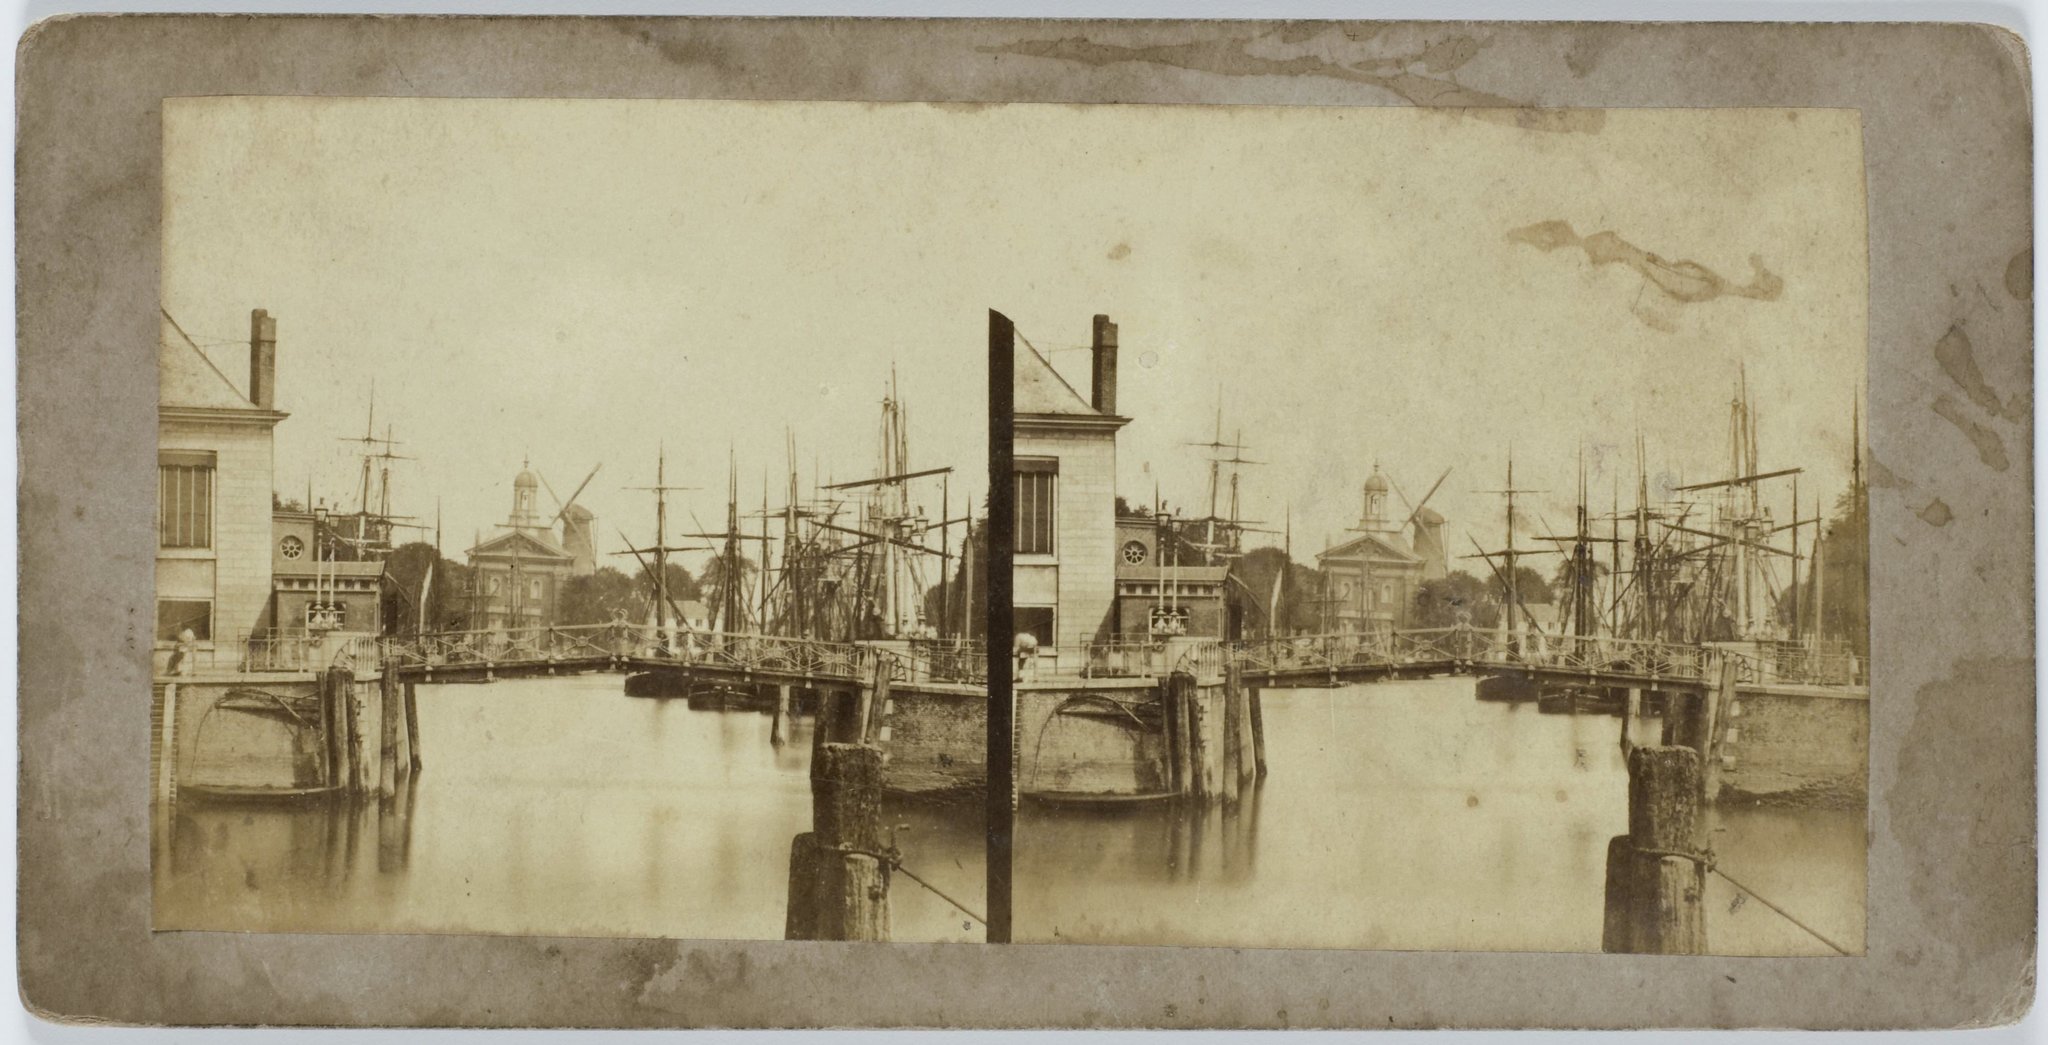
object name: stereograph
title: Brug in Rotterdam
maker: alexis gaudin et frère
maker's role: fotograaf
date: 1858-1860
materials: cardboard, paper, photographic support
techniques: albumen print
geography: france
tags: rotterdam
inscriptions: label: ‘N. 52. / PONT A ROTTERDAM’, title: ‘Brug te Rotterdam’